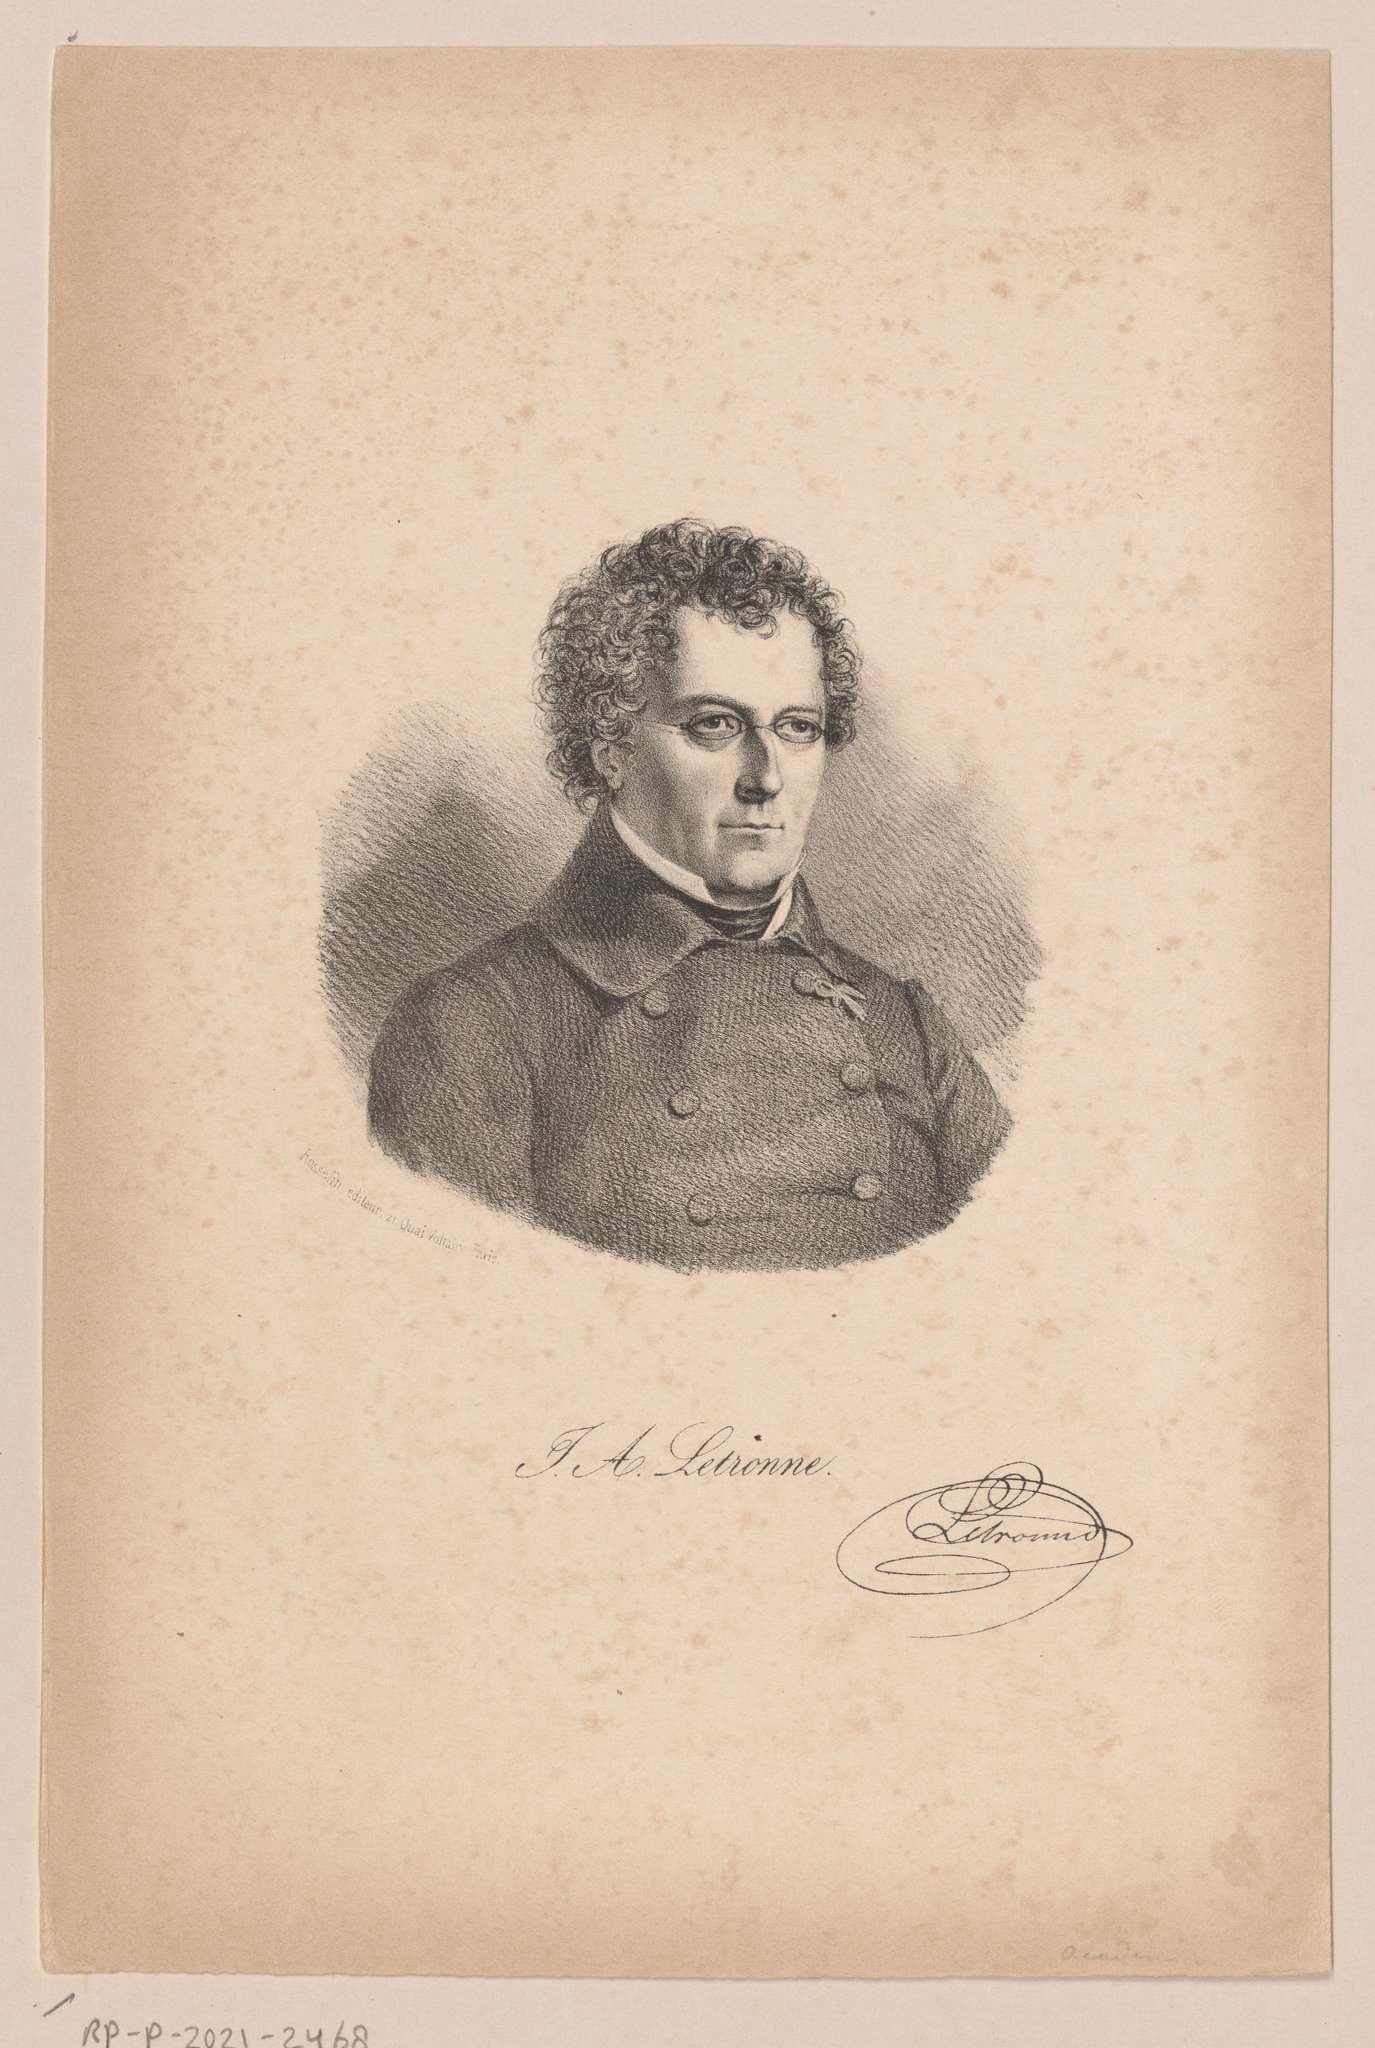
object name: print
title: Portret van Jean-Antoine Letronne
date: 1830-1861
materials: paper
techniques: lithograph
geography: france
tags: paris, eyeglasses, spectacles, history and archaeology (+ portrait of scholar, scientist), historical persons